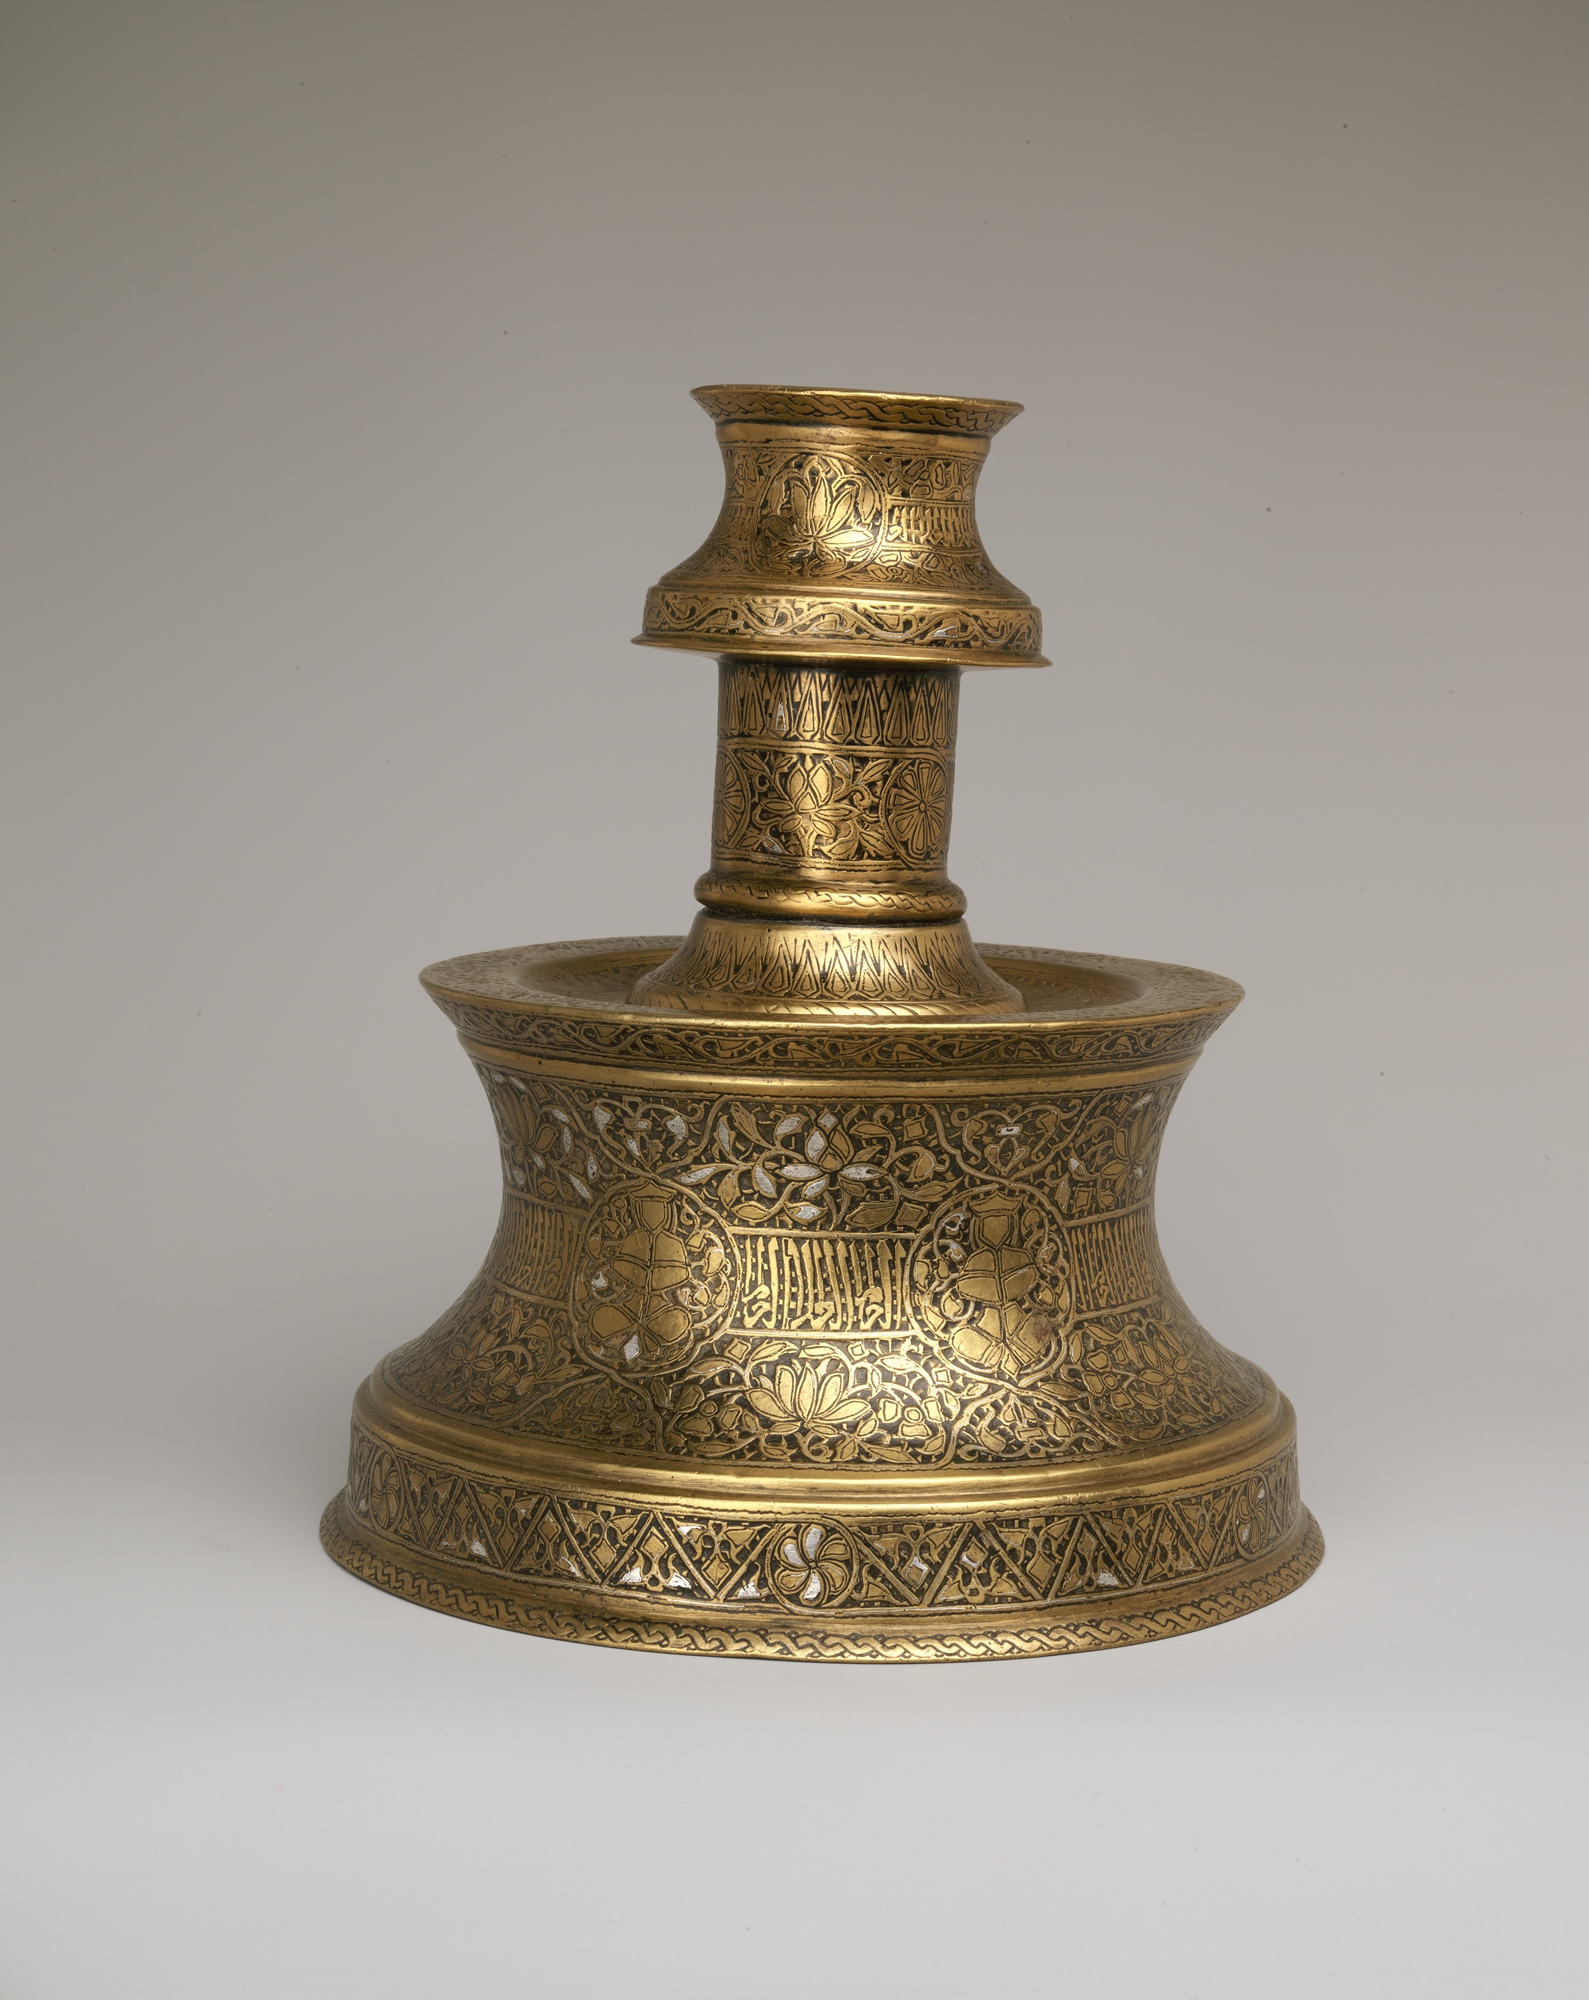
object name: candlestick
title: Candlestick with Repeating Seated Figure, Inscription, and Flowers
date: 1351-1400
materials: brass, silver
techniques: casting, engraving, inlay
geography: iran